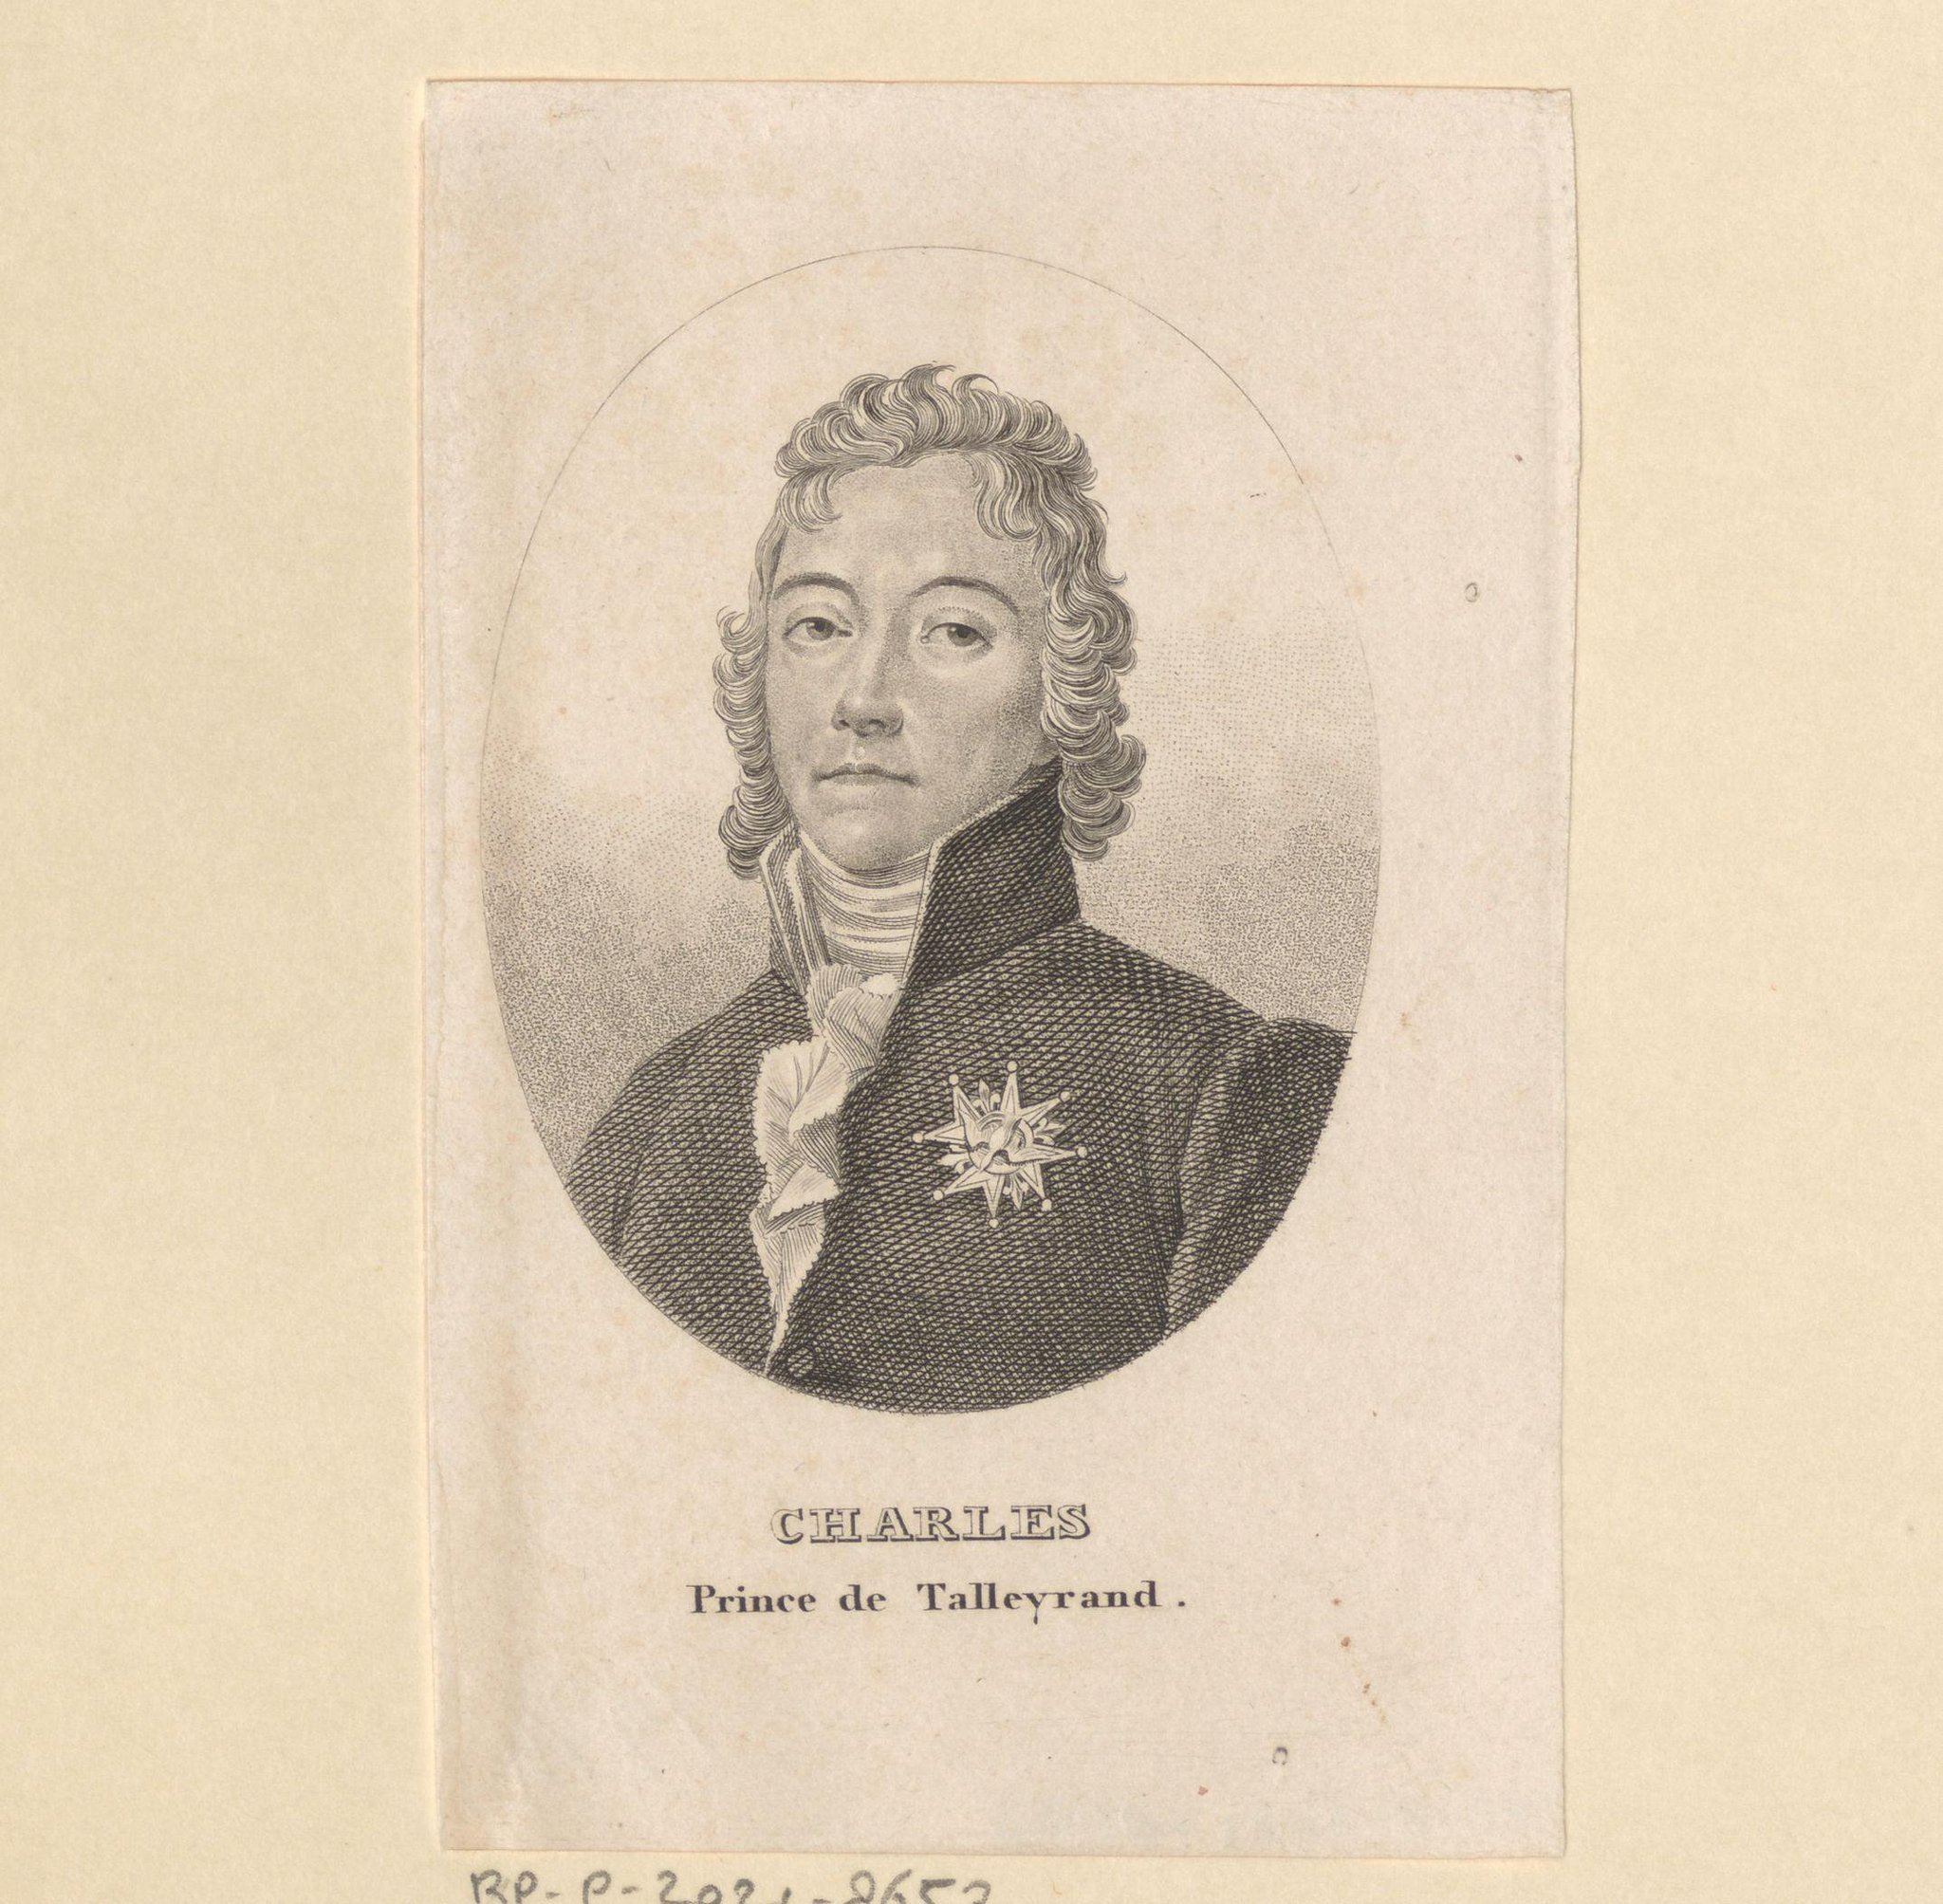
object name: print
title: Portret van Charles Maurice de Talleyrand-Périgord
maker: Anonymous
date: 1800-1849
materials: paper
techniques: etching, roulette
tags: paris, politician, charles maurice hertog van talleyrand-périgord, historical persons, politician, e.g. party leader